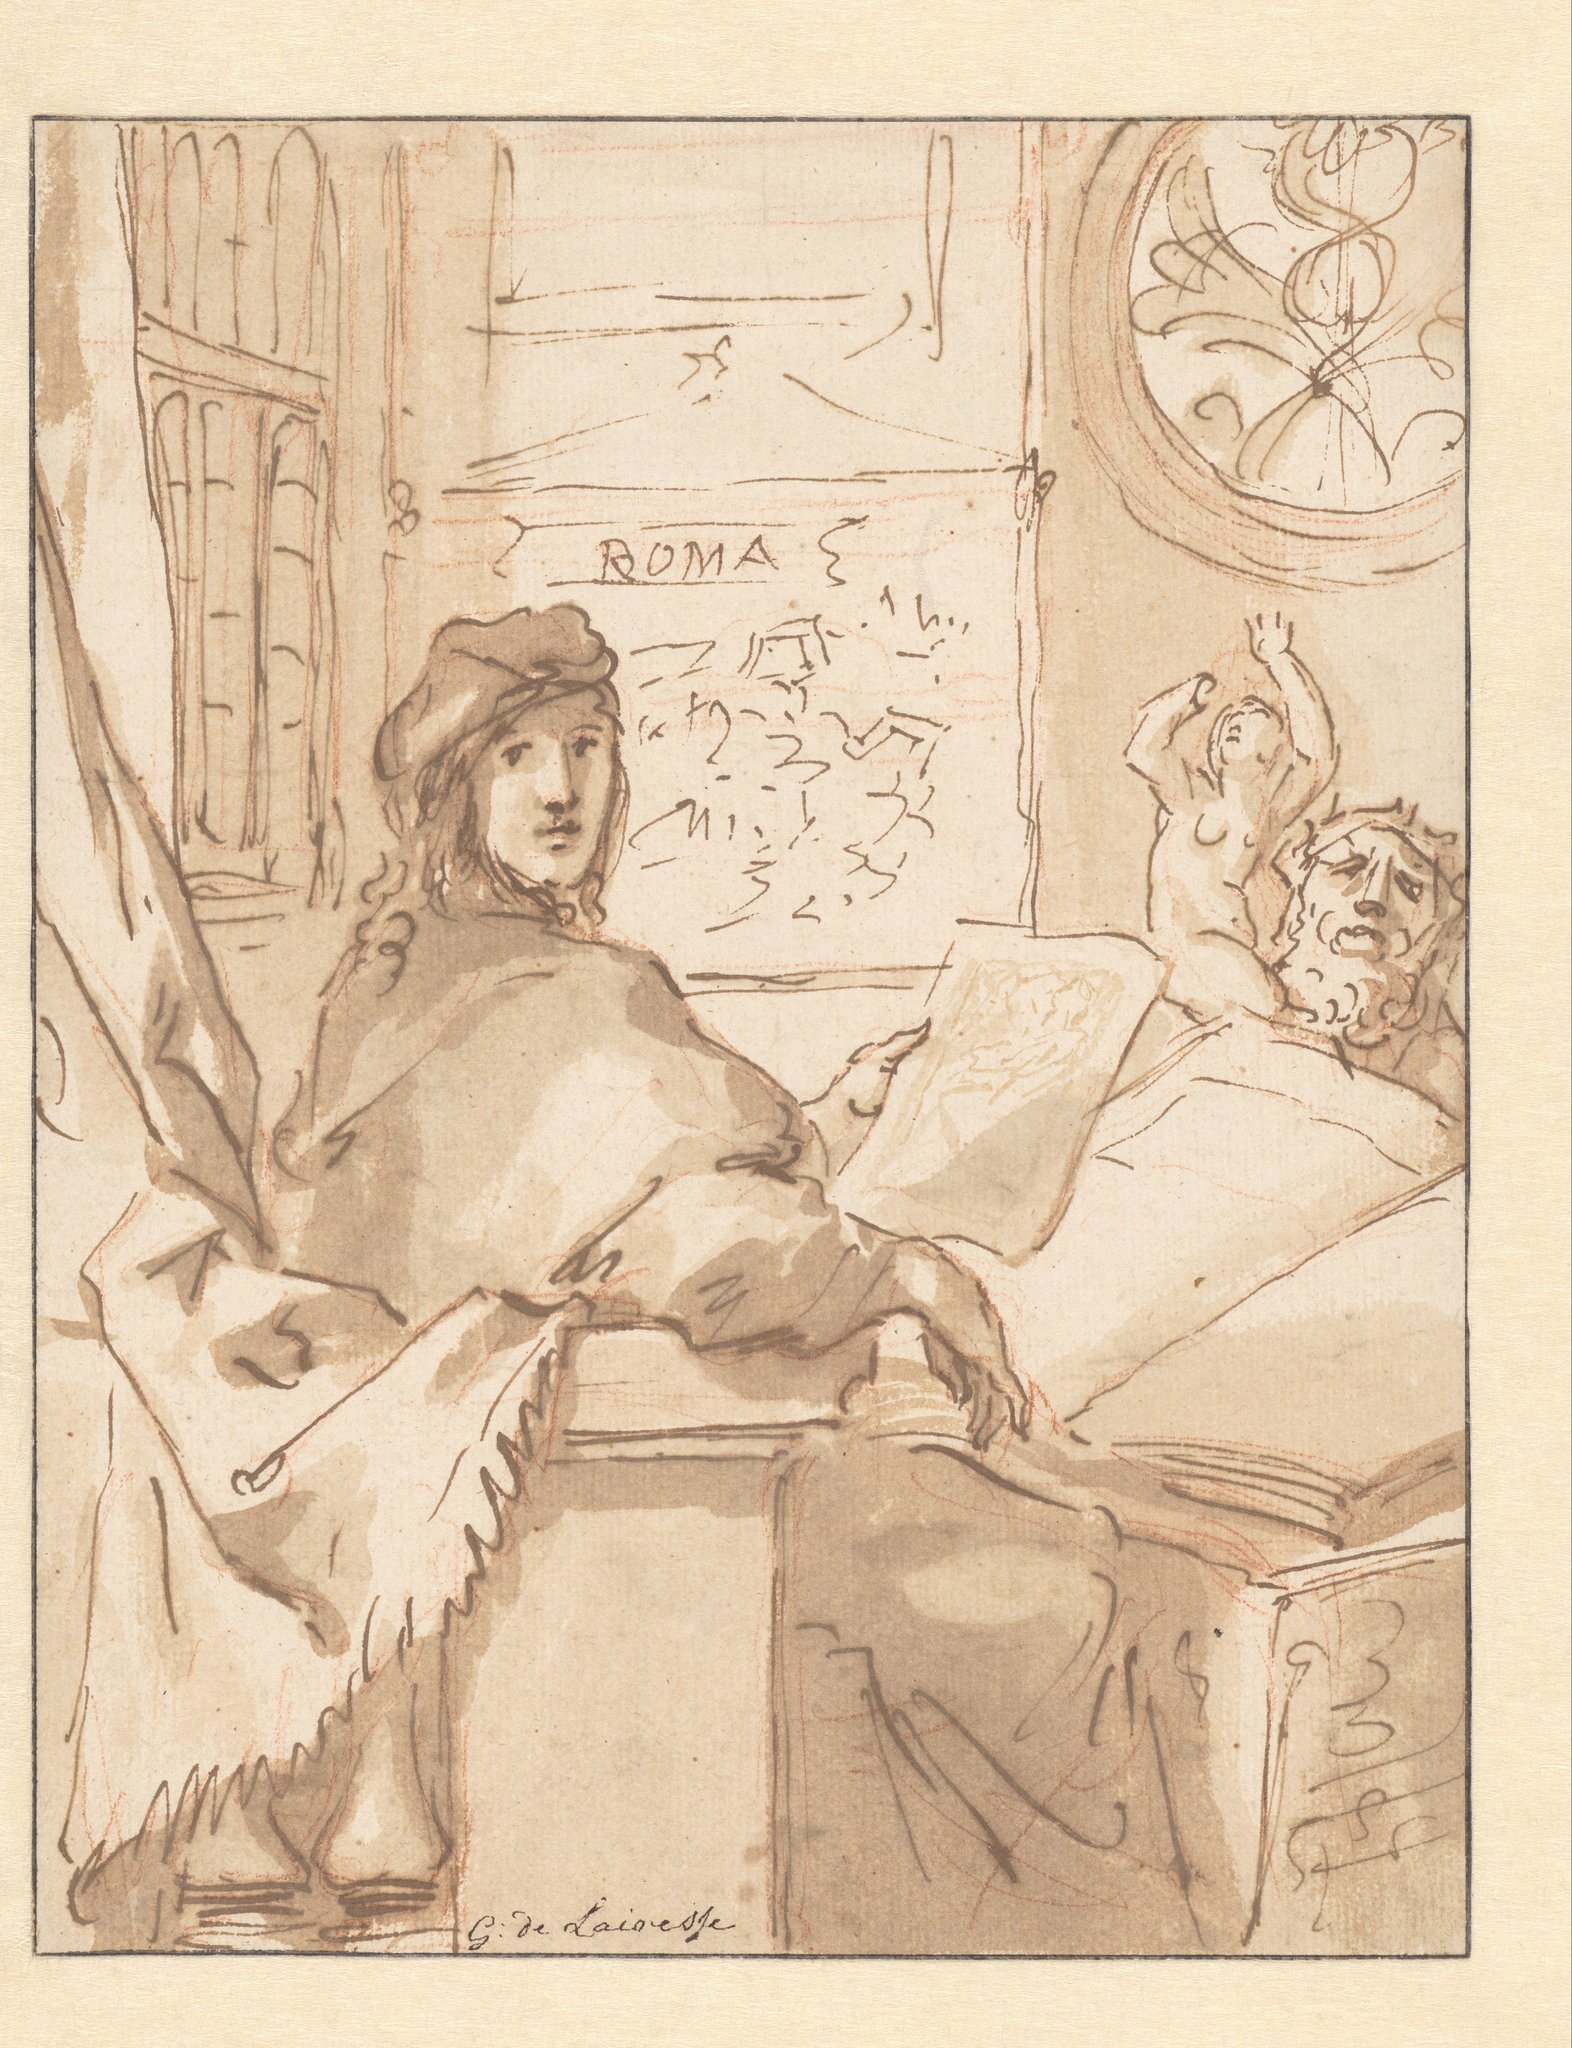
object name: drawing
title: Portret van Philips de Flines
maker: gerard de lairesse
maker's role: draughtsman, painter, print maker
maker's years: 1641-1711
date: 1670-1675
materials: chalk, ink, paper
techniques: brush, pen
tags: historical persons, art collector